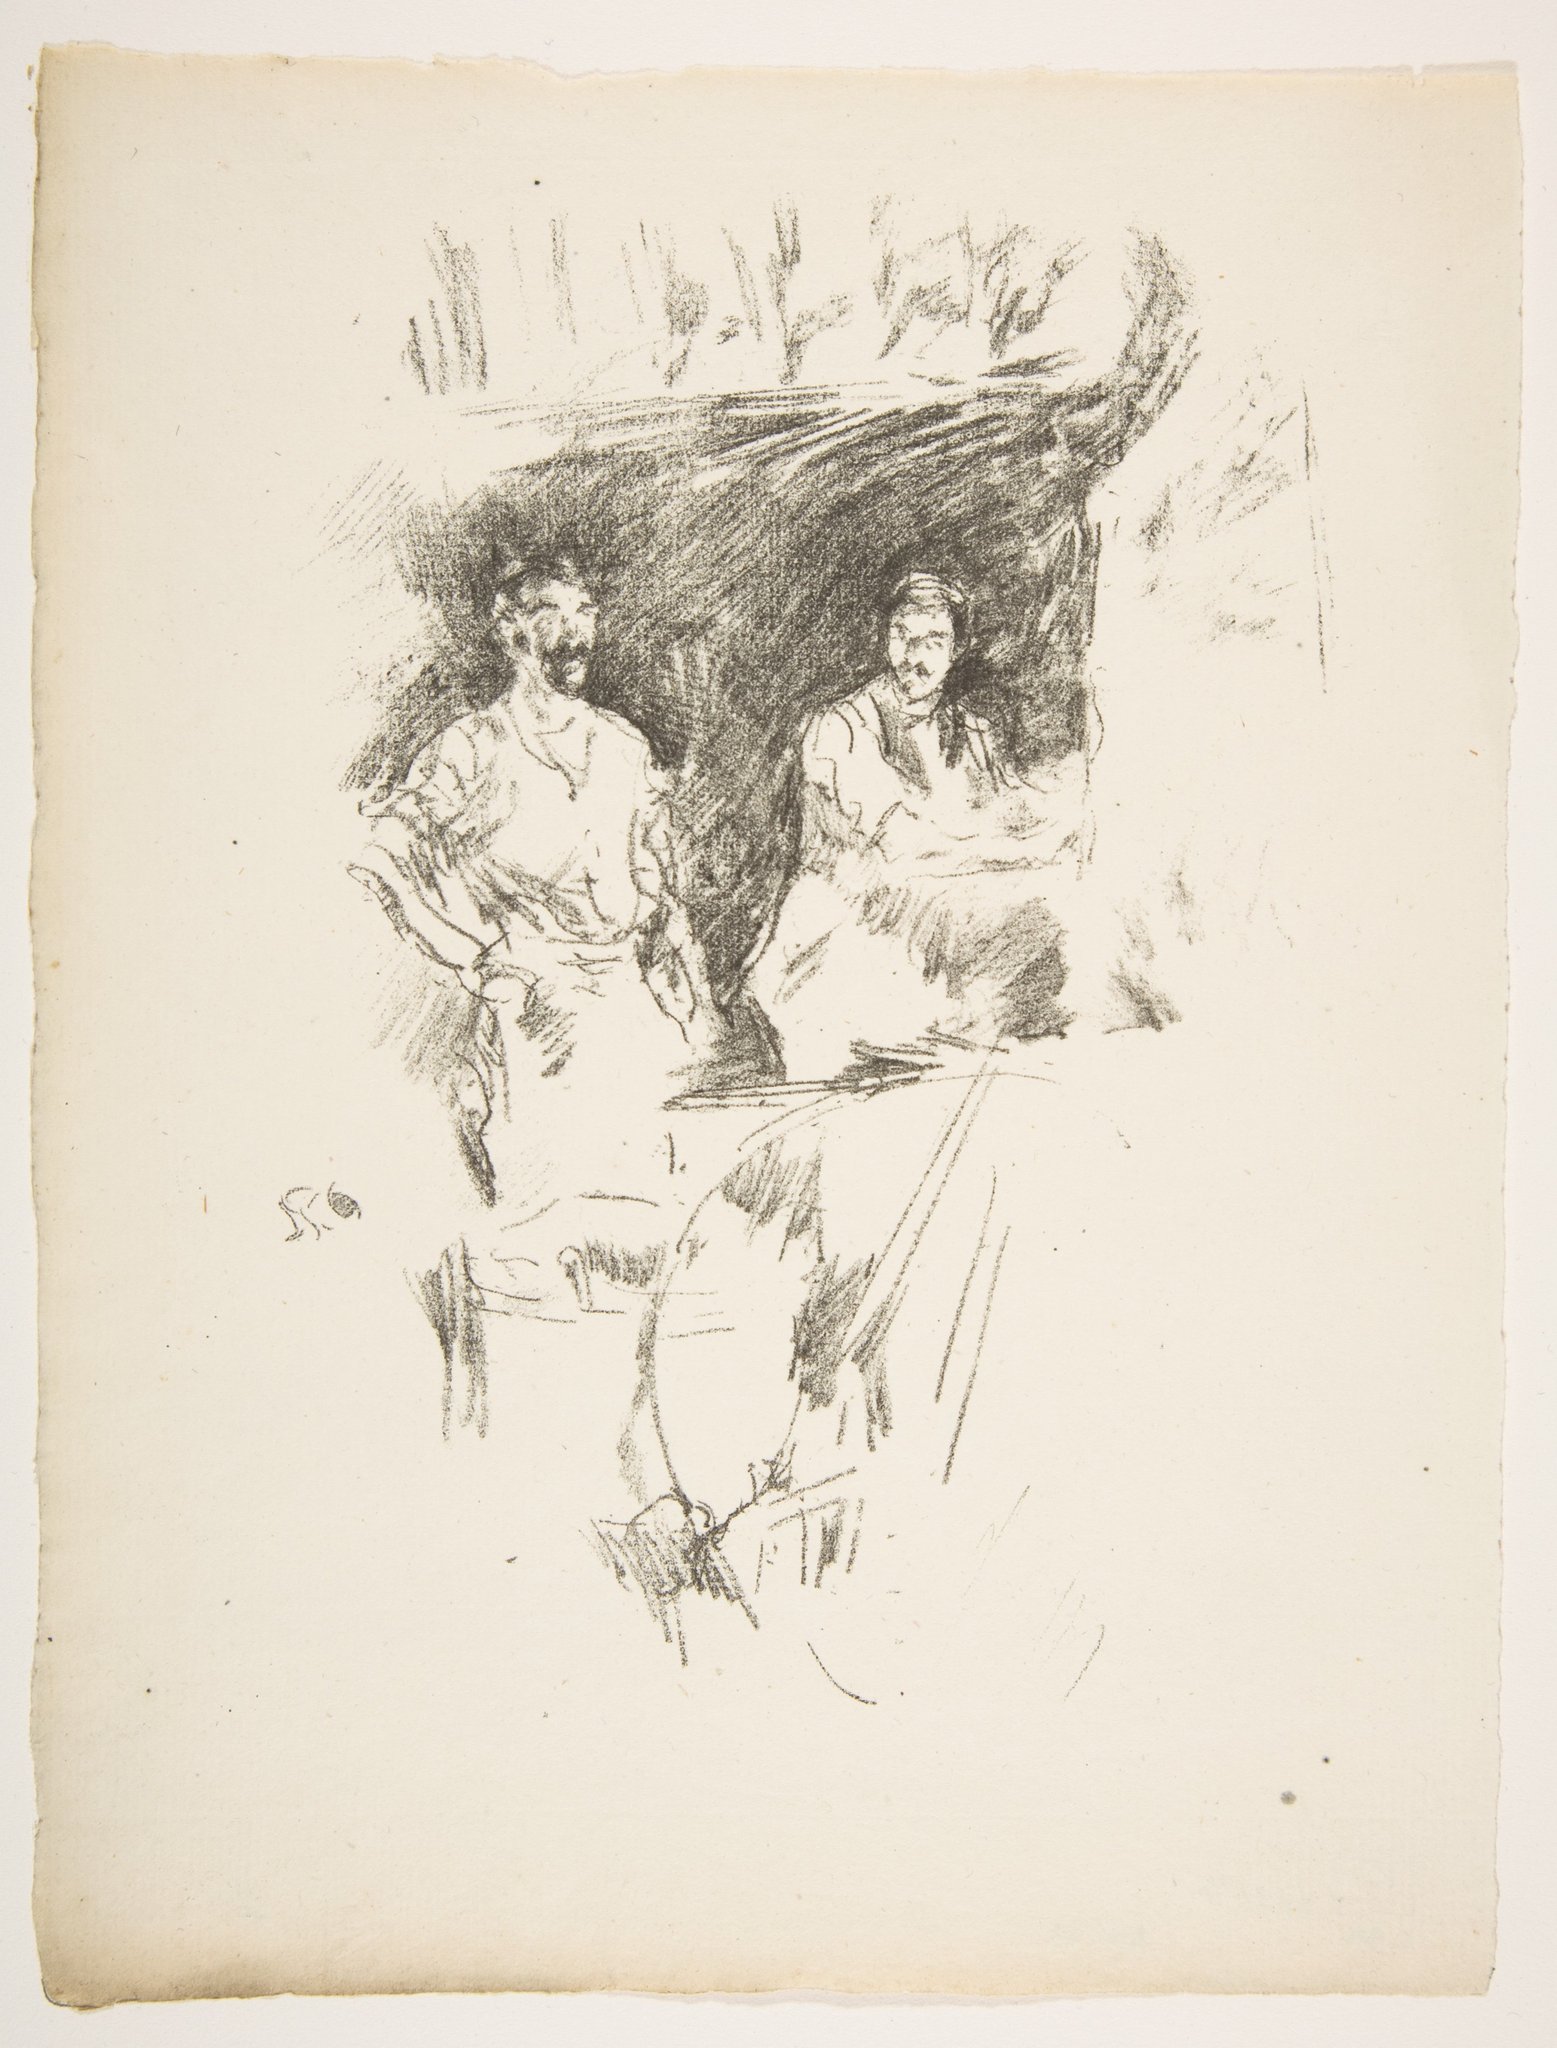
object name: print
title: The Brothers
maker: james mcneill whistler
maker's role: artist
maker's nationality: american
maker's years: 1834-1903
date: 1895-1896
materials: ink, paper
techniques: printing, lithography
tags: men